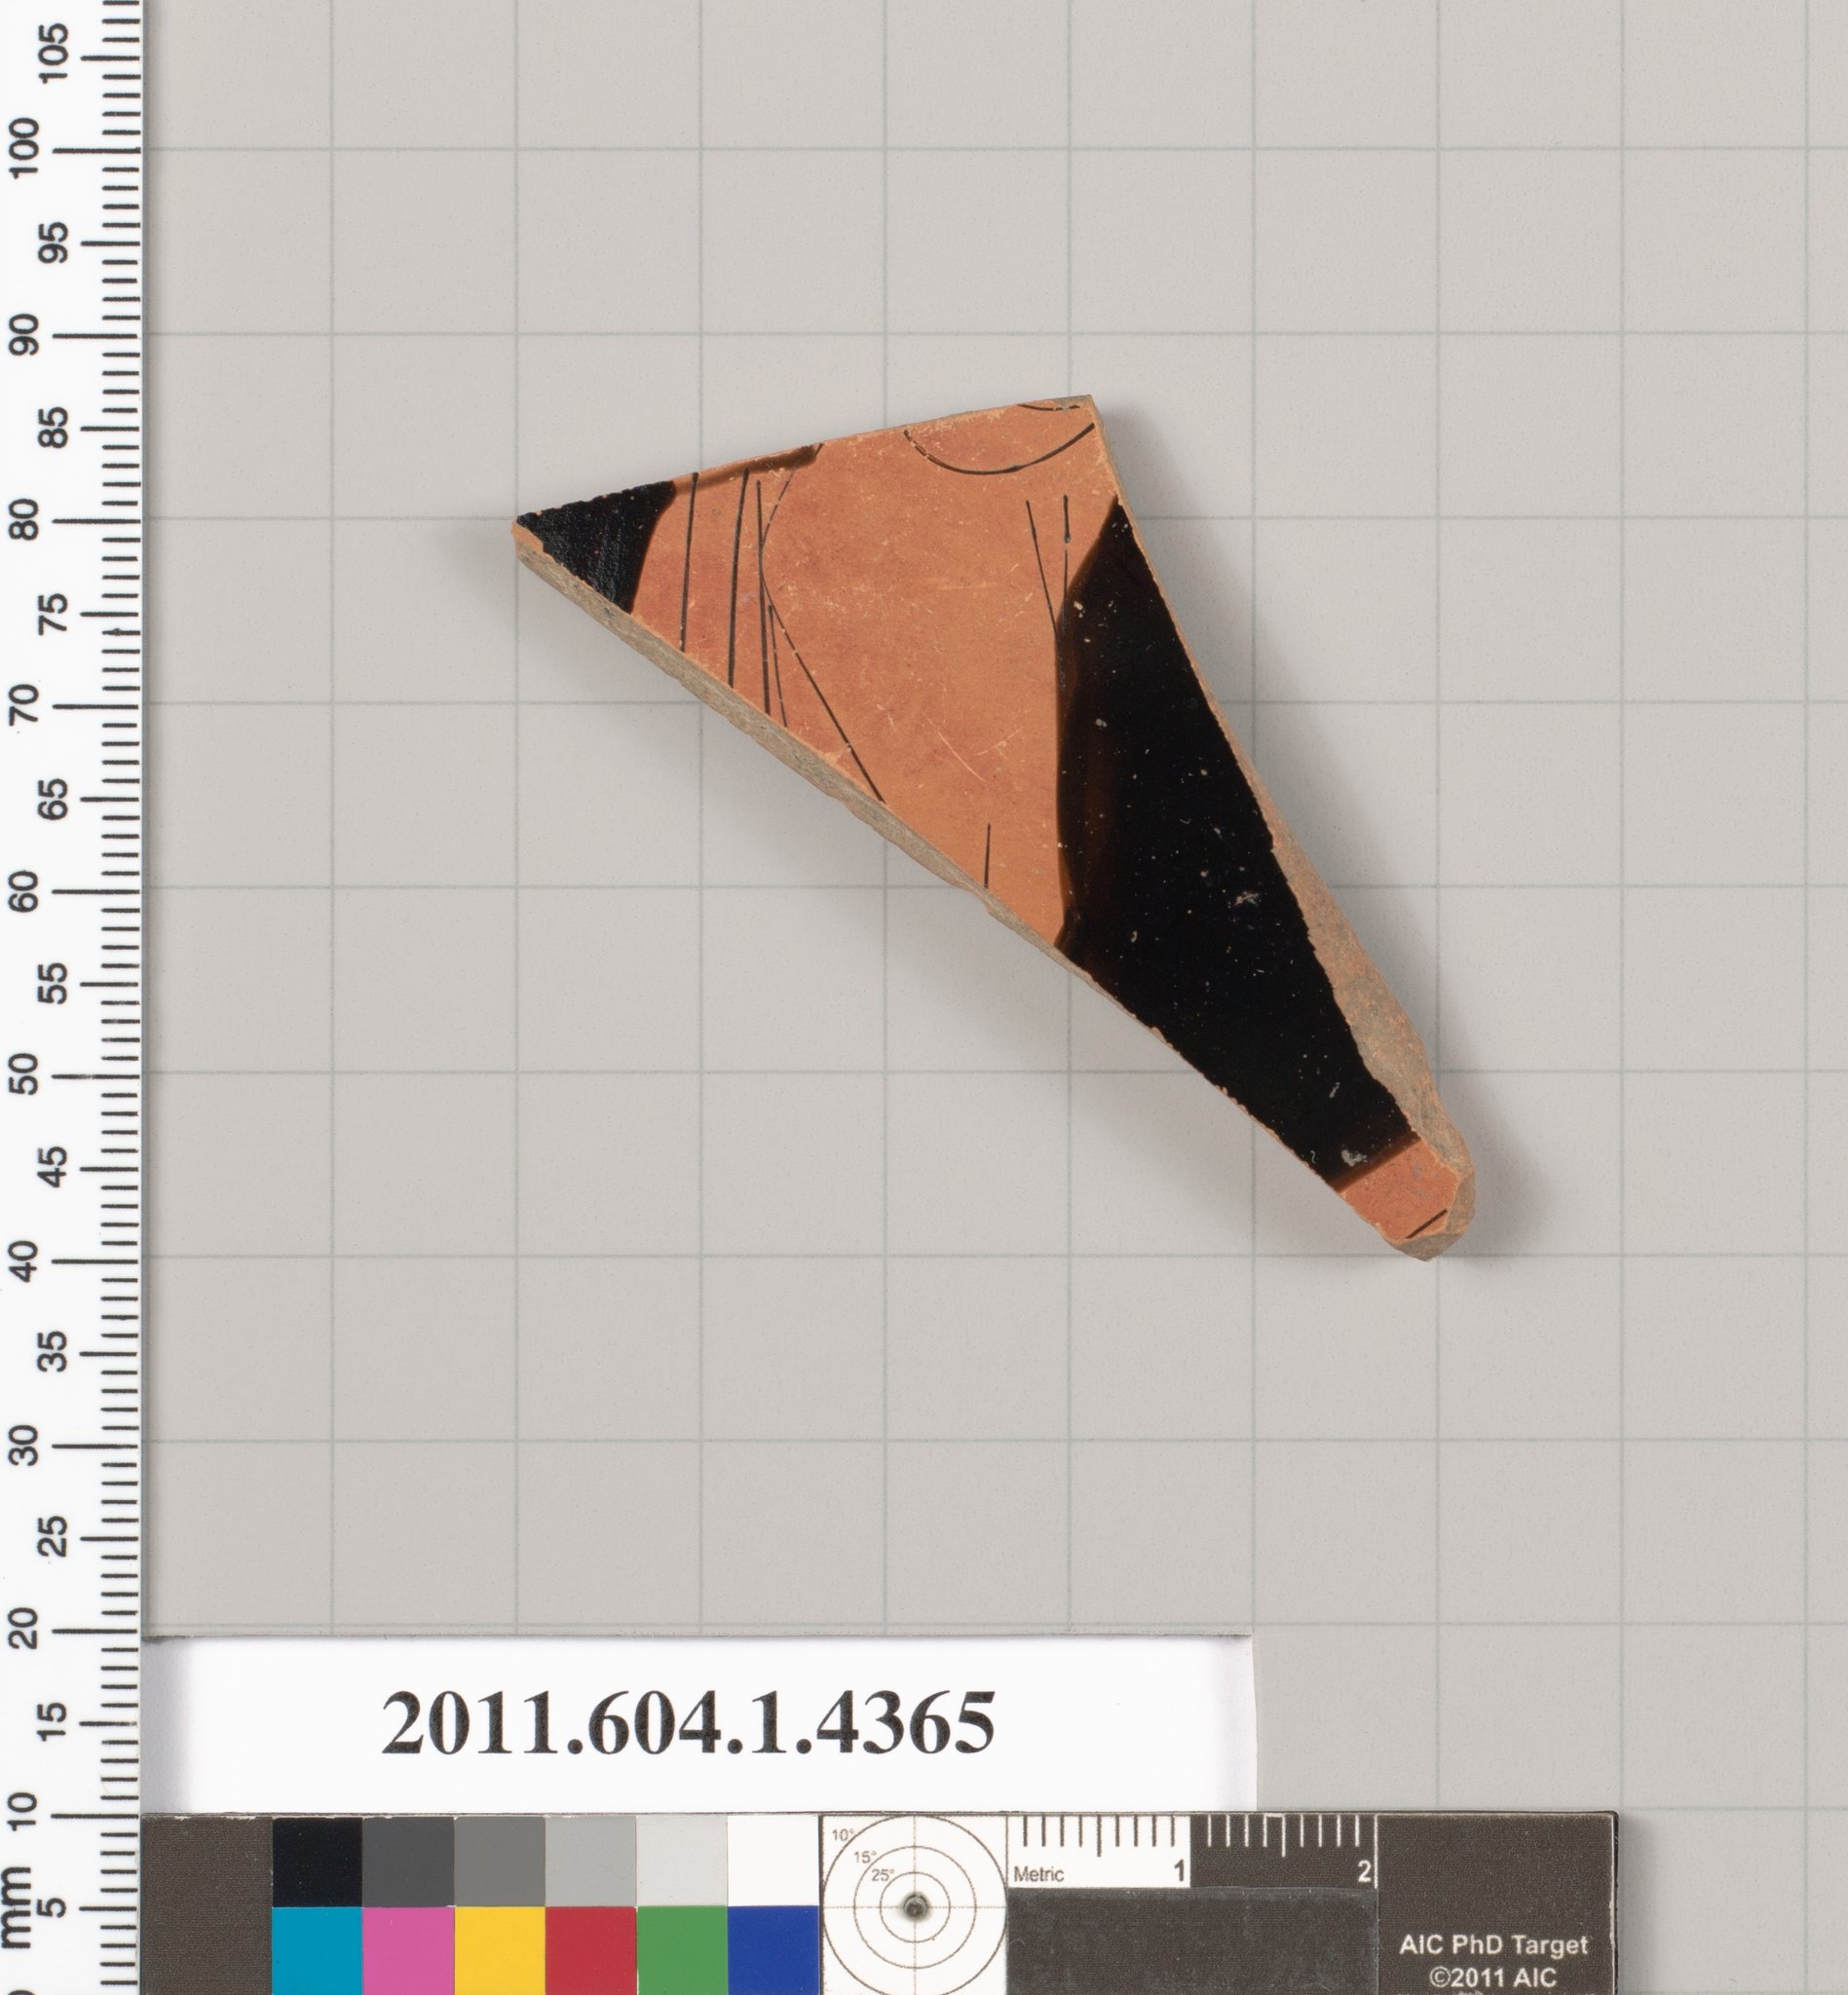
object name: kylix fragment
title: Terracotta fragment of a kylix (drinking cup)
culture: greek, attic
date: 475-451 BCE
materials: terracotta